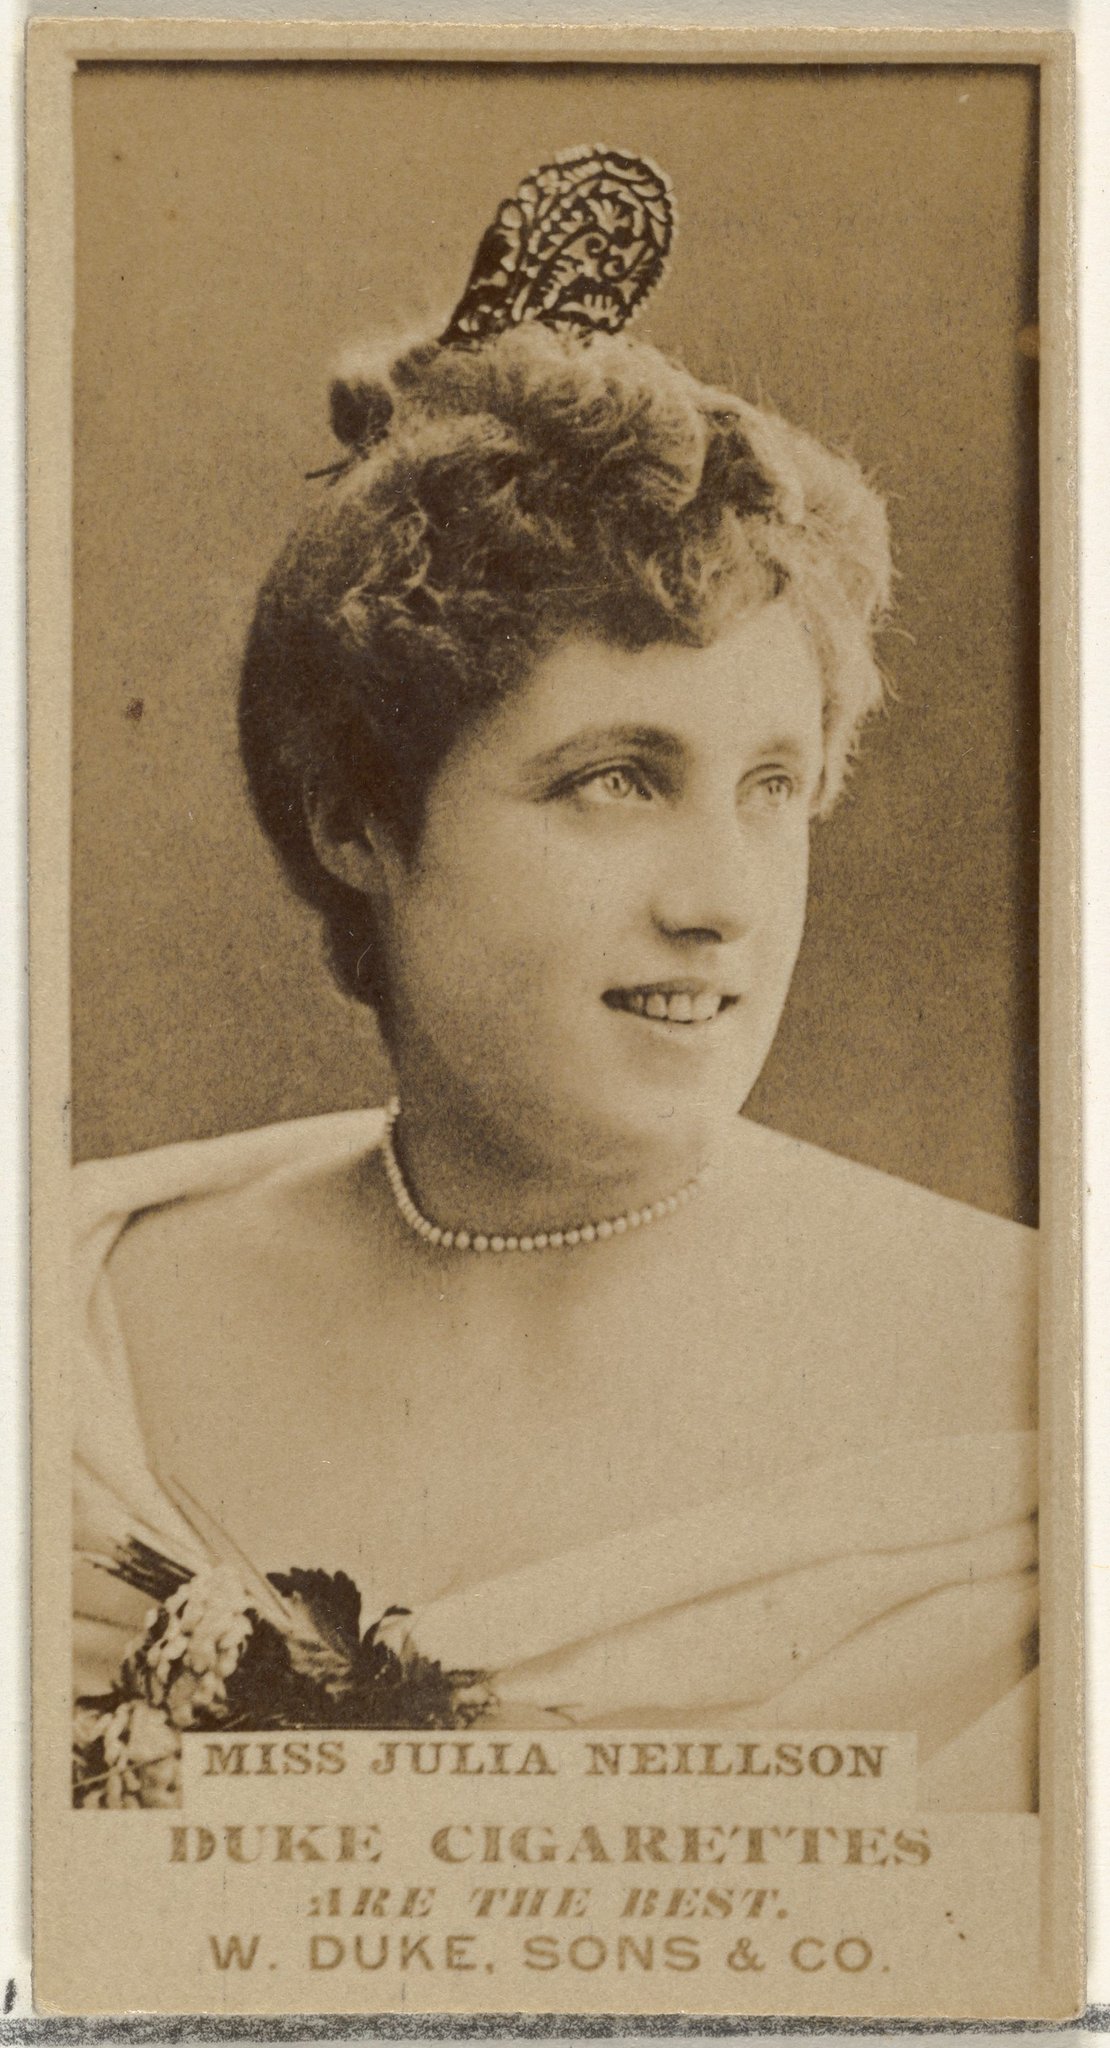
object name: photograph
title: Miss Julia Neillson, from the Actors and Actresses series (N145-7) issued by Duke Sons & Co. to promote Duke Cigarettes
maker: w. duke, sons & co.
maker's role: publisher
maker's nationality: american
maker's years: 1870-1920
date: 1880-1889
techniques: albumen silver print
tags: portraits,women,actresses